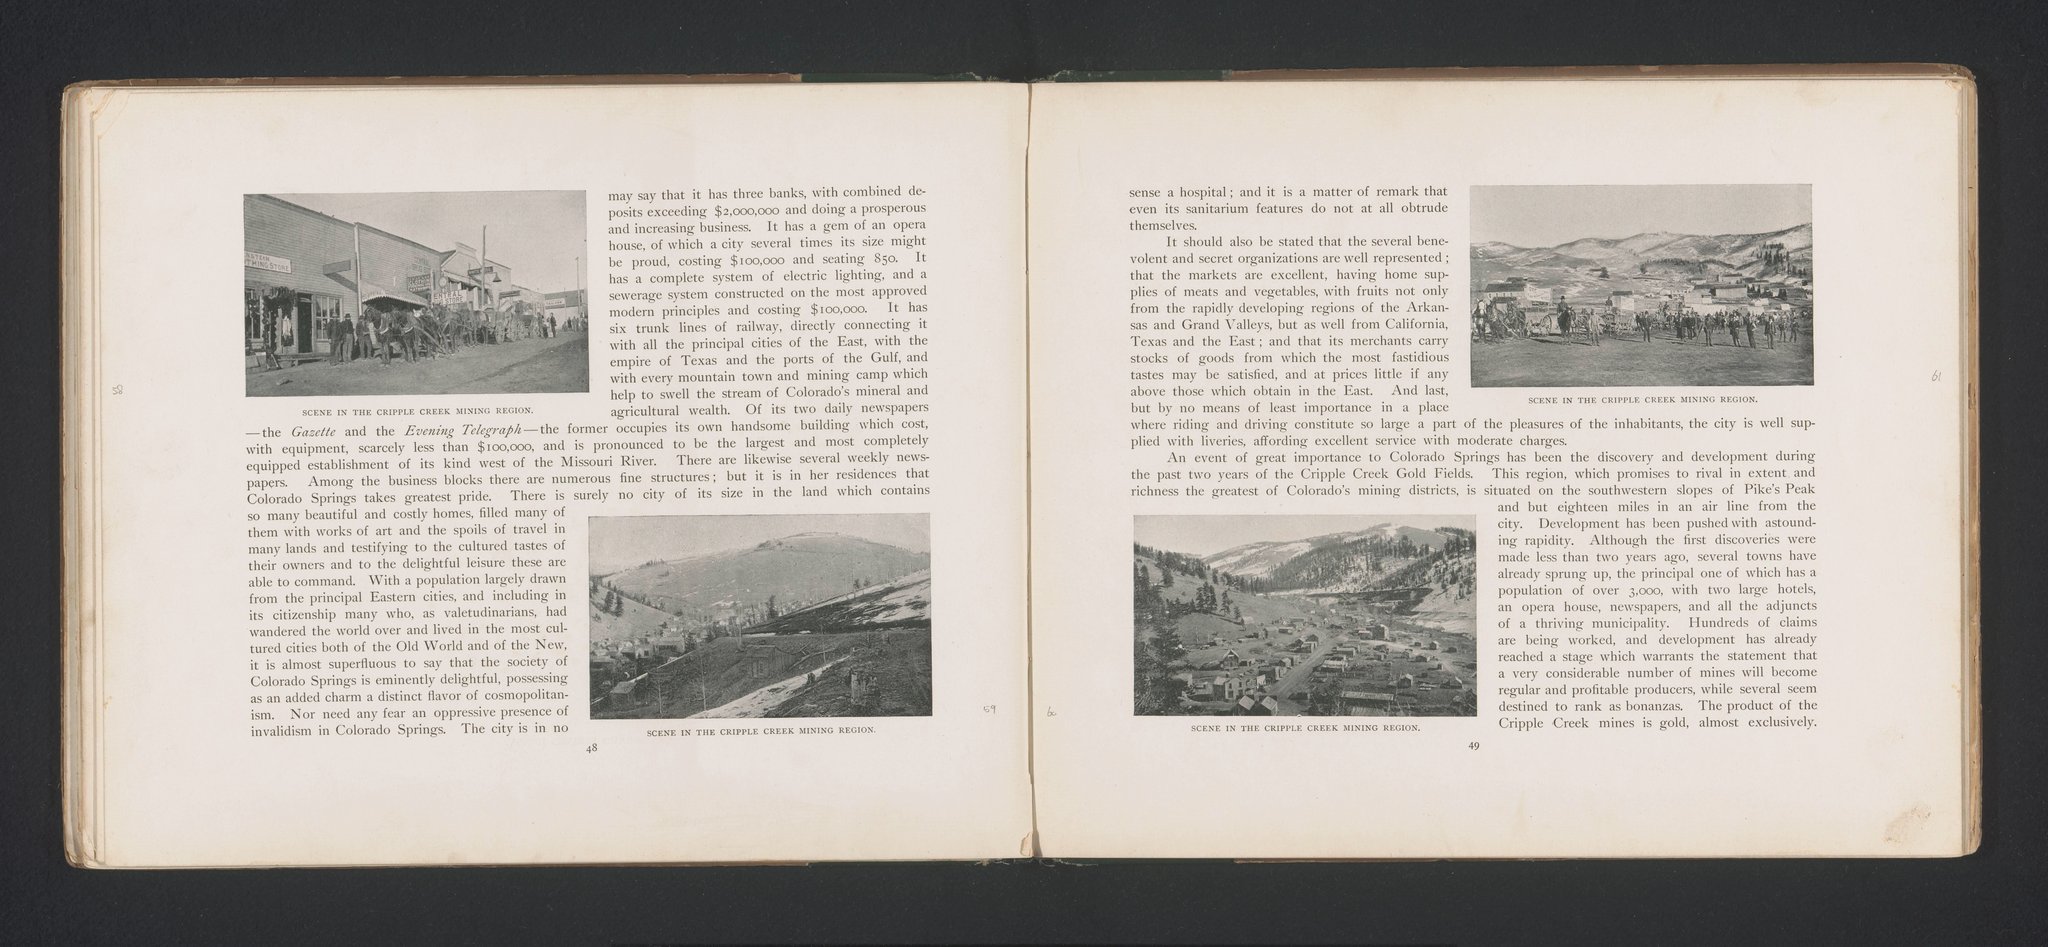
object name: page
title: Scene in the Cripple Creek mining region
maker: Anonymous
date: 1888-1893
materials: paper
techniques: autotype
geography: cripple creek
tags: city-view in general; 'veduta', mountains